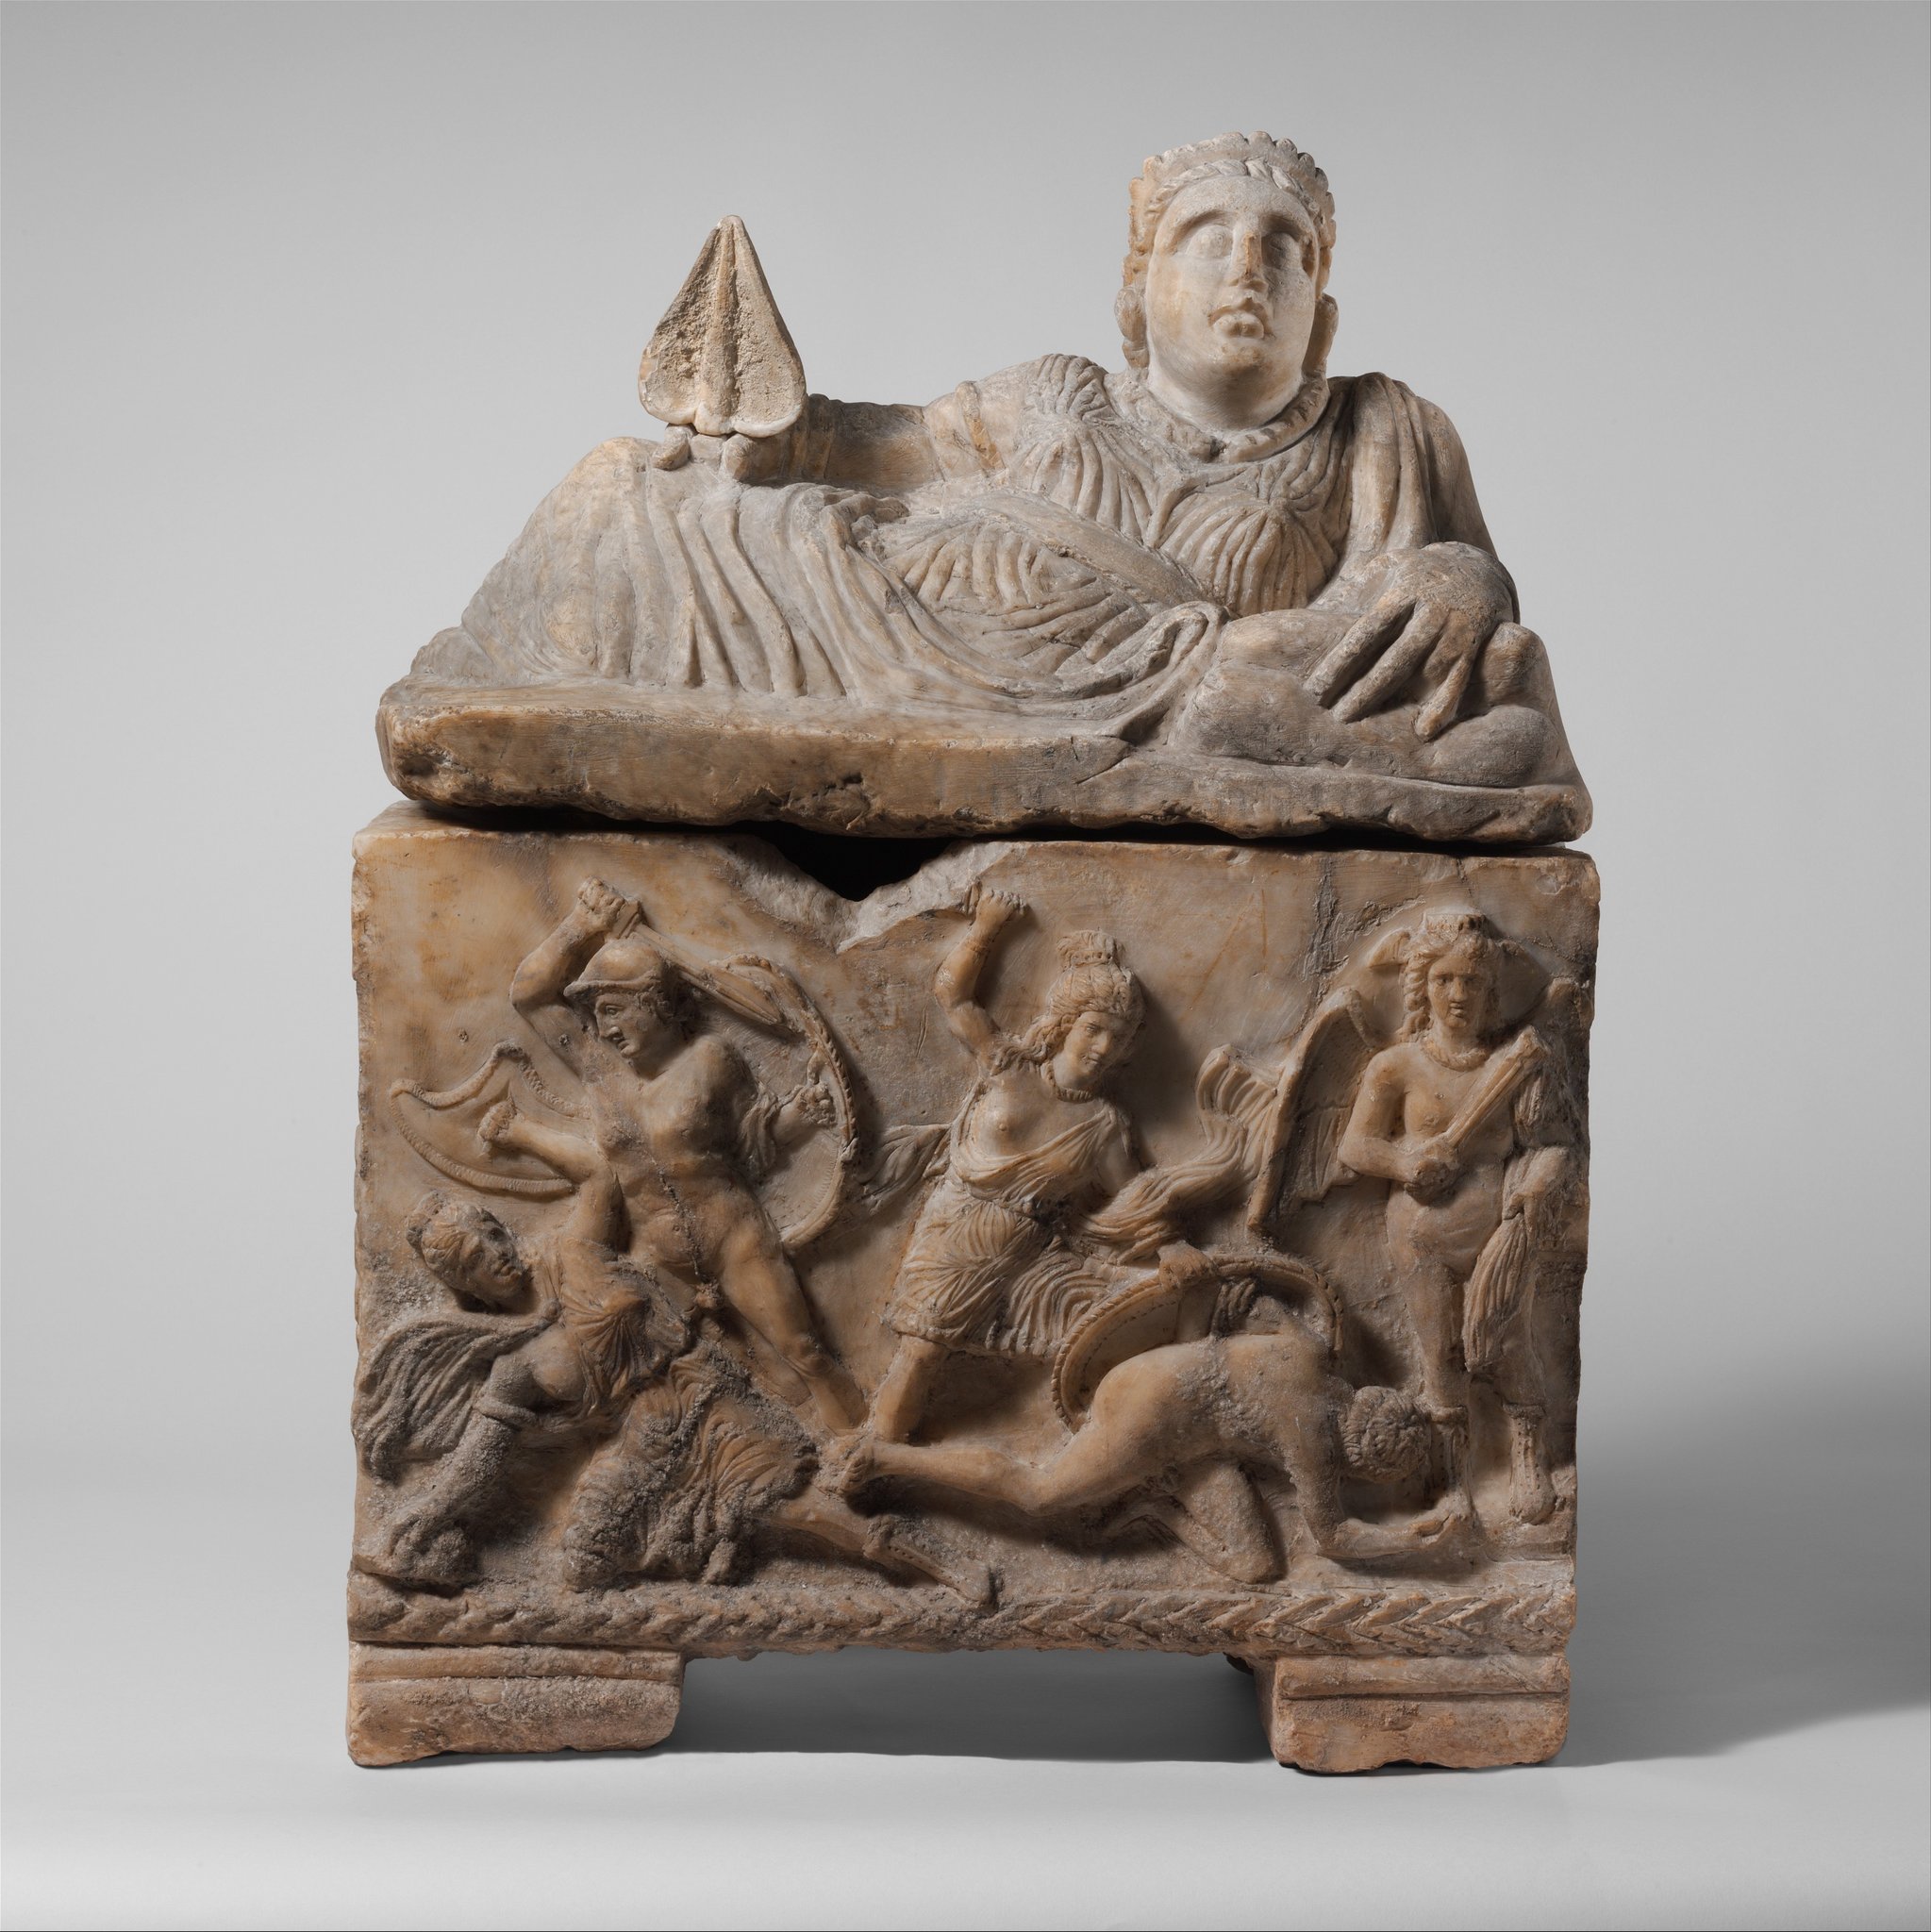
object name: cinerary urn with lid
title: Alabaster cinerary urn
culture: etruscan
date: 300-201 BCE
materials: alabaster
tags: battles,shields,men,women,amazons